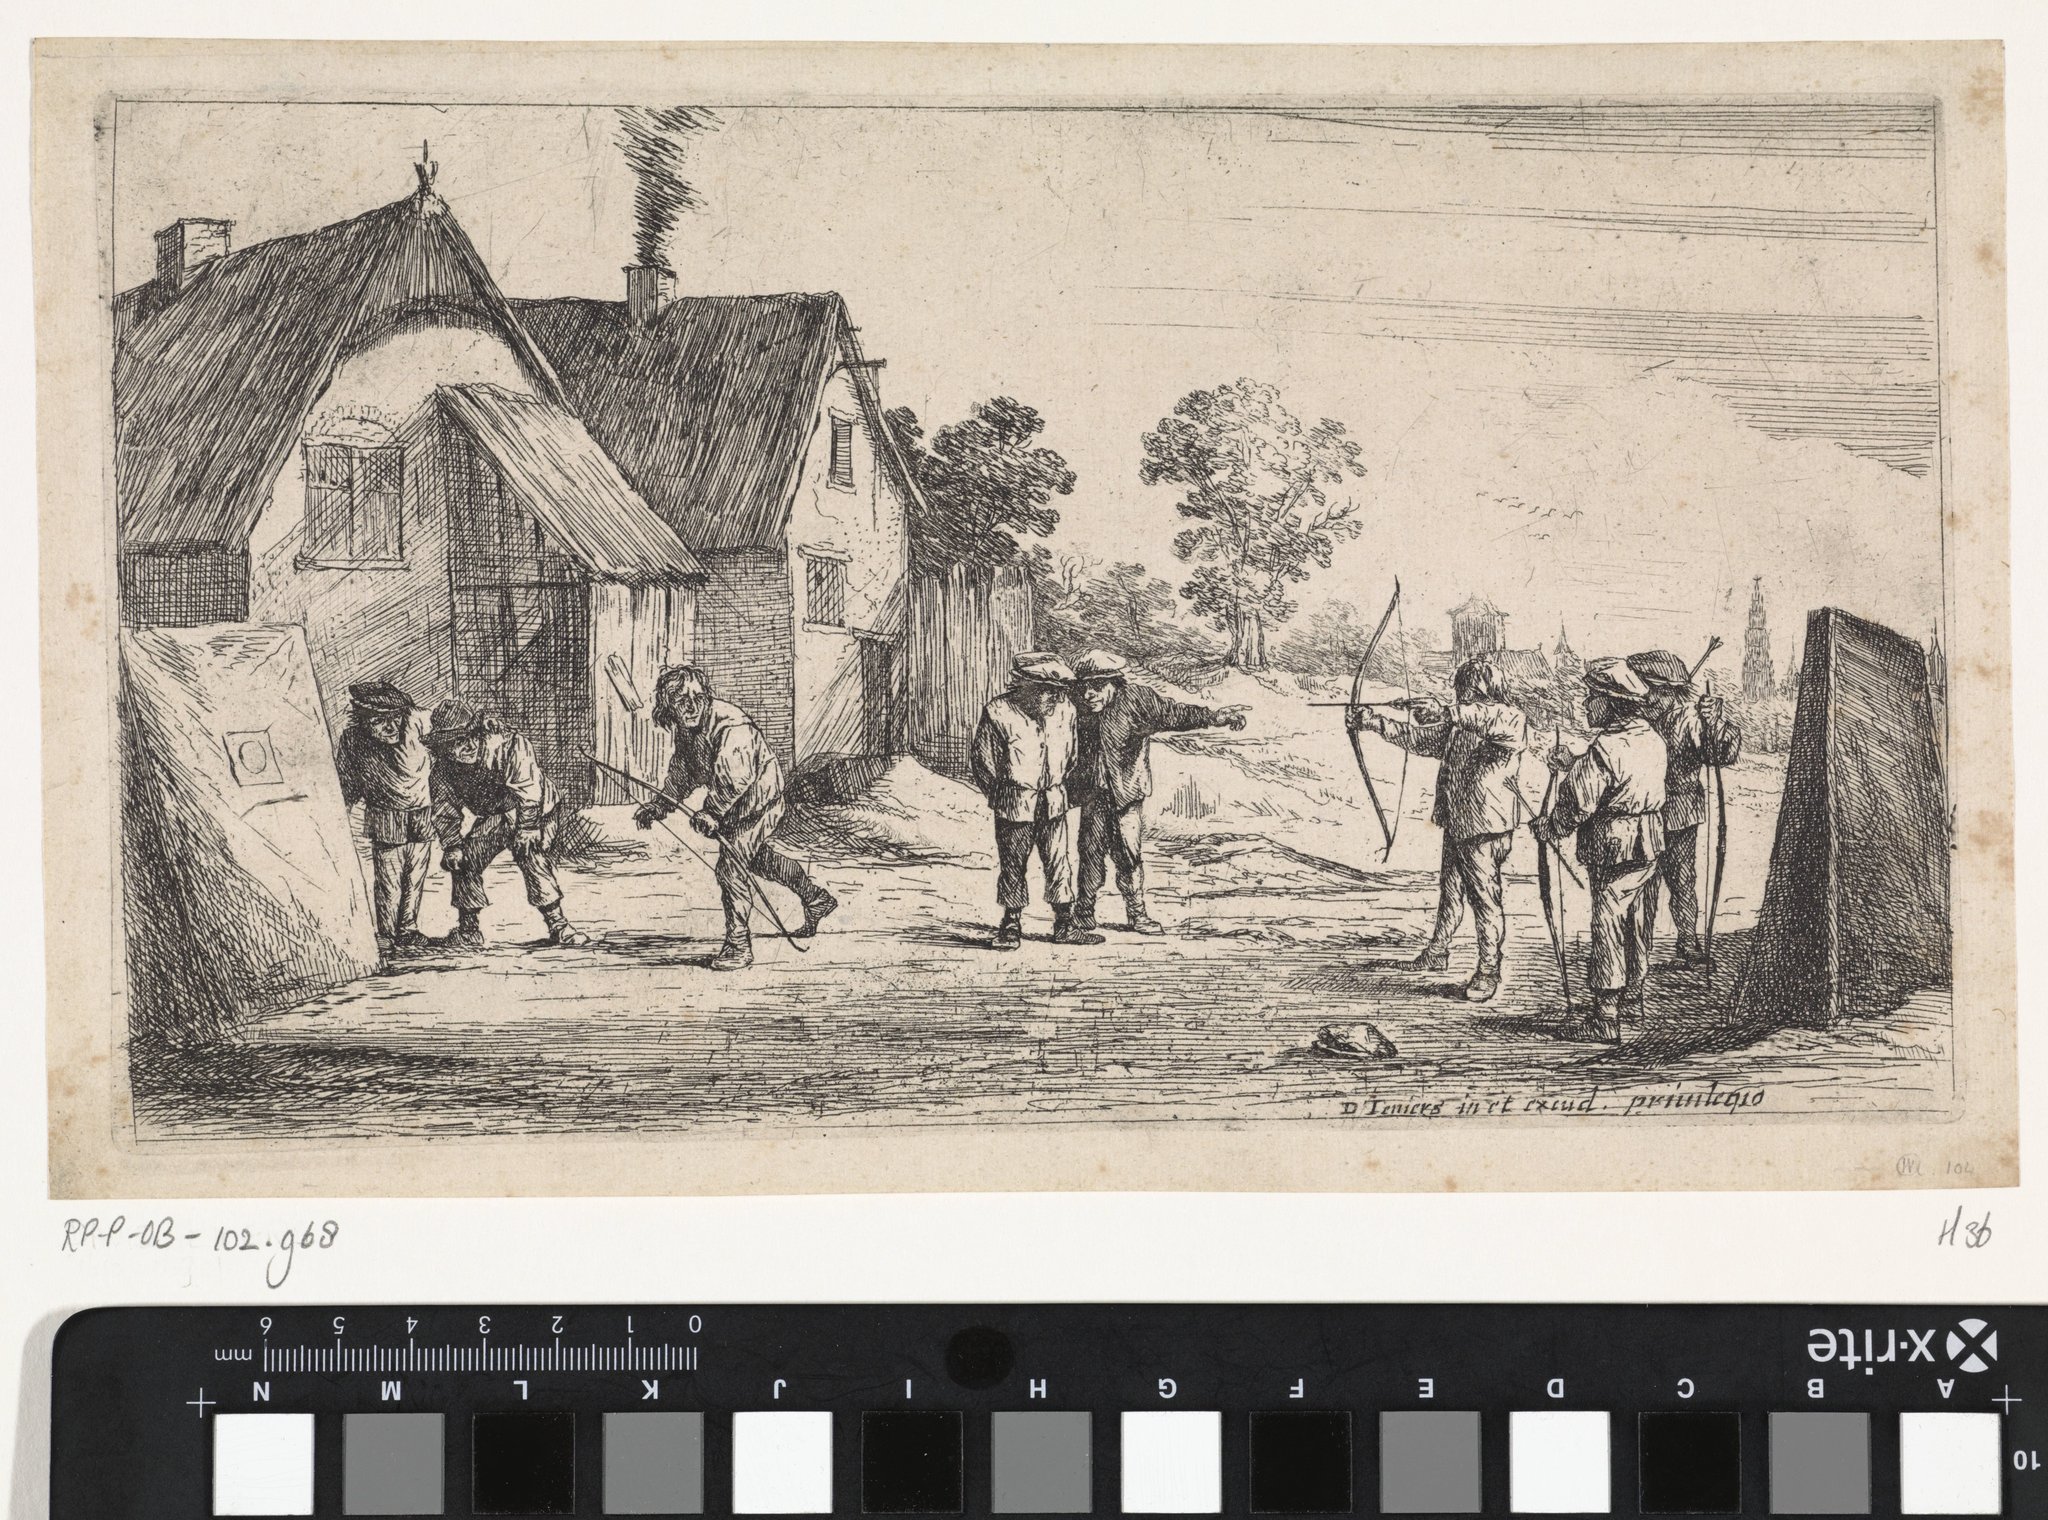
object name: print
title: Boogschieters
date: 1626-1690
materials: paper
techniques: etching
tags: landscapes, archer's weapons: bow, shooting with bow and arrow, archery (~ games of skill)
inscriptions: collector's mark: Lugt 2228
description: Boogschutters schieten pijlen op een doel. Andere mannen kijken toe. Links twee huizen.